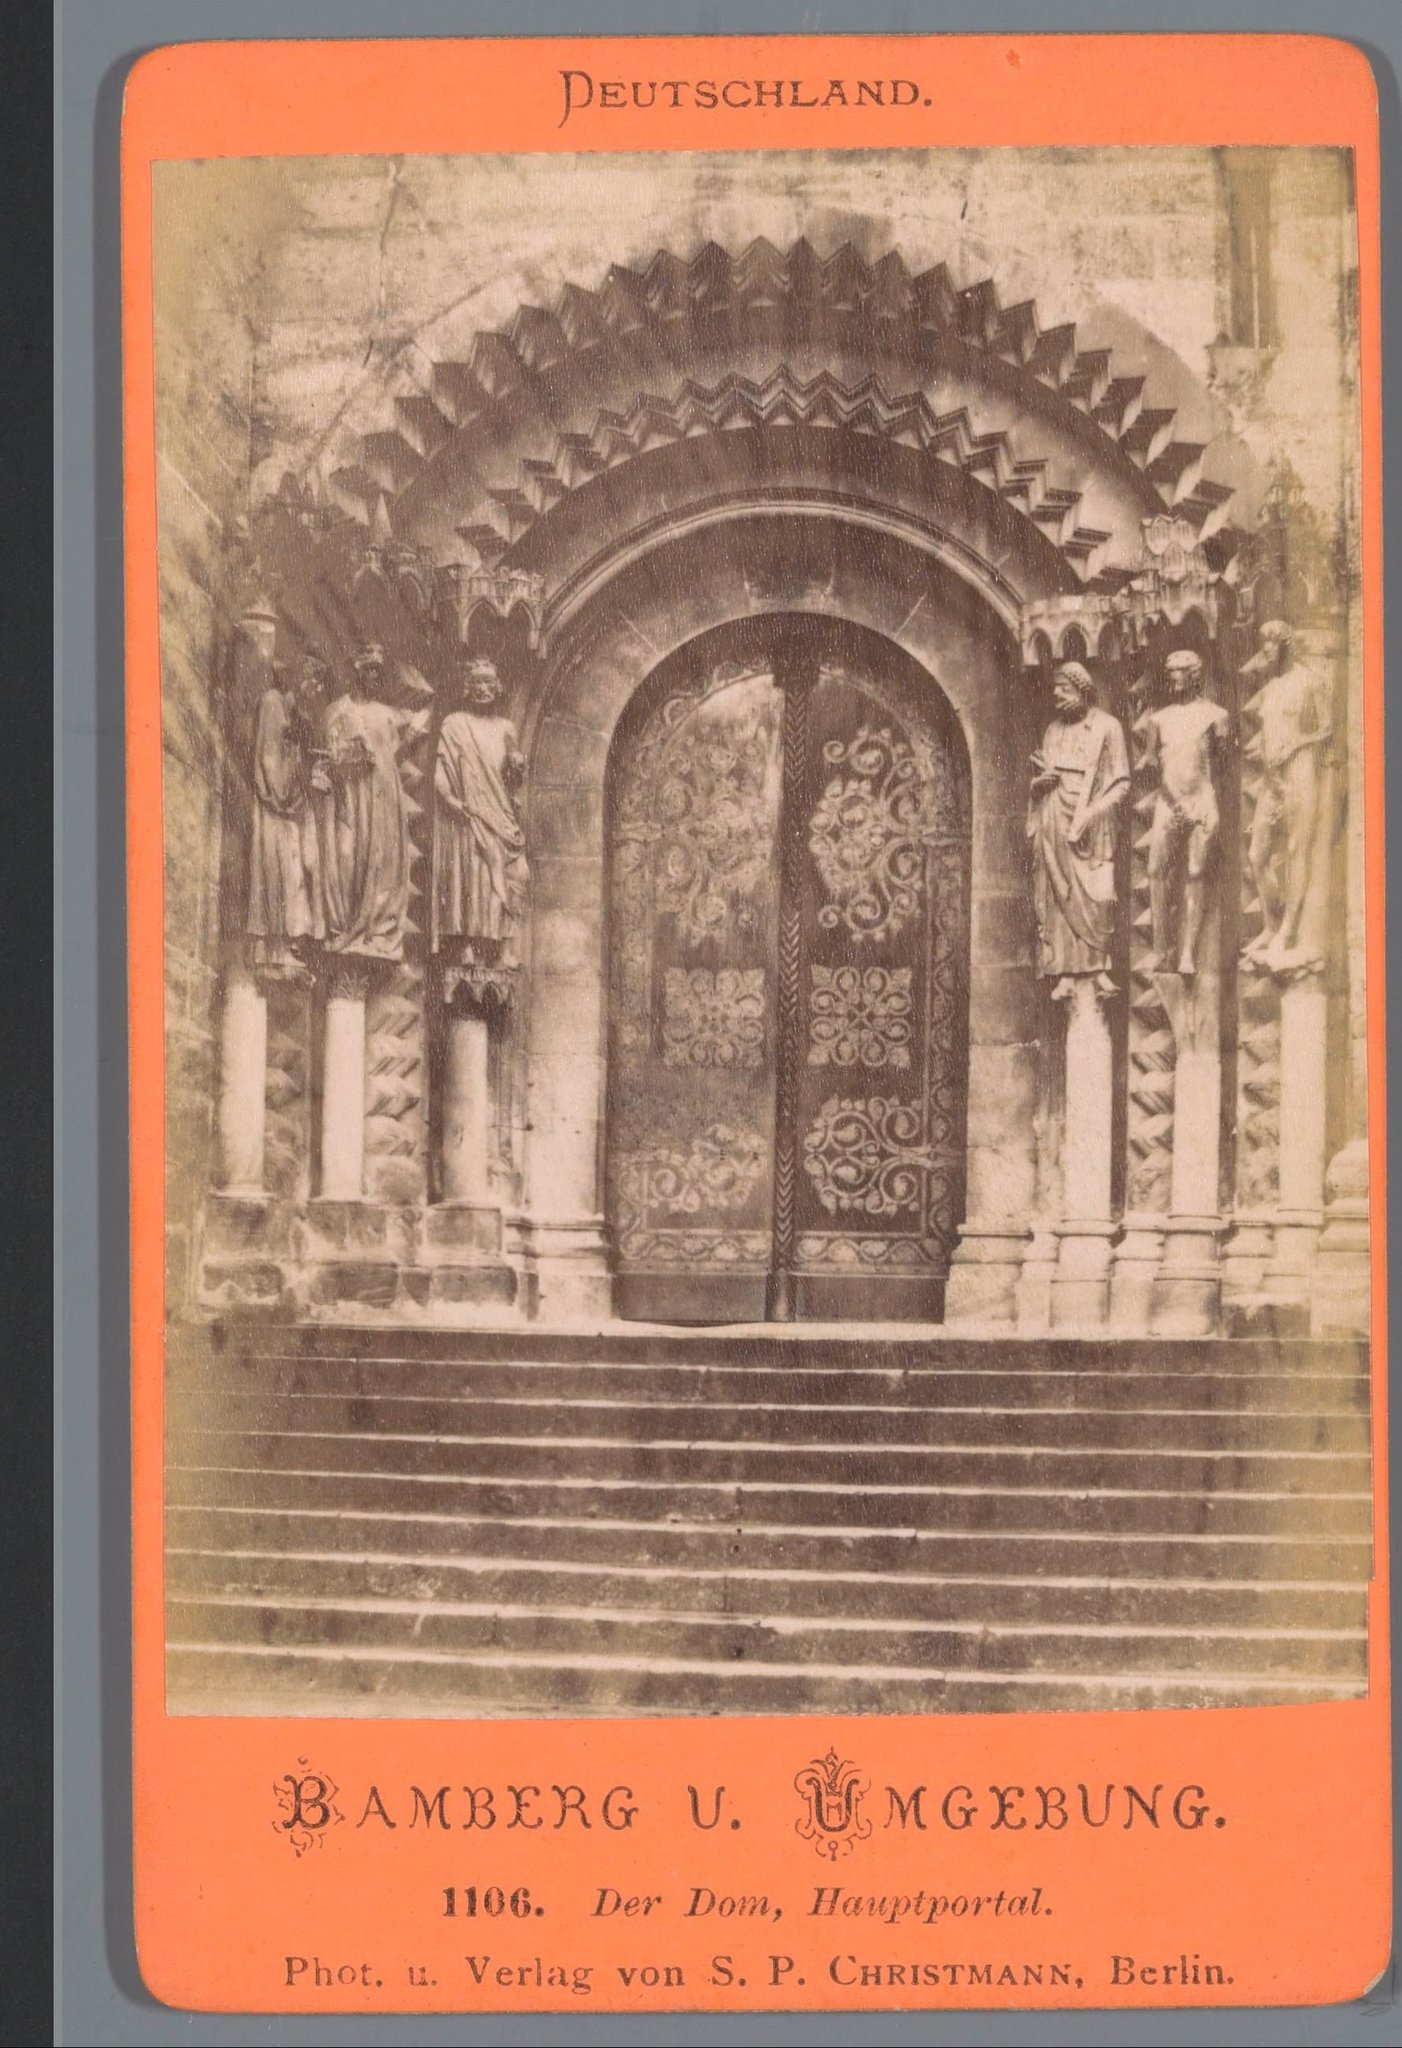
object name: carte de visite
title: Portaal van de Dom van Bamberg, Duitsland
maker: s.p. christmann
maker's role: publisher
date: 1860-1890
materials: cardboard, paper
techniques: albumen print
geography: bamberg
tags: parts of church exterior and annexes: portal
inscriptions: number: ‘1106.’